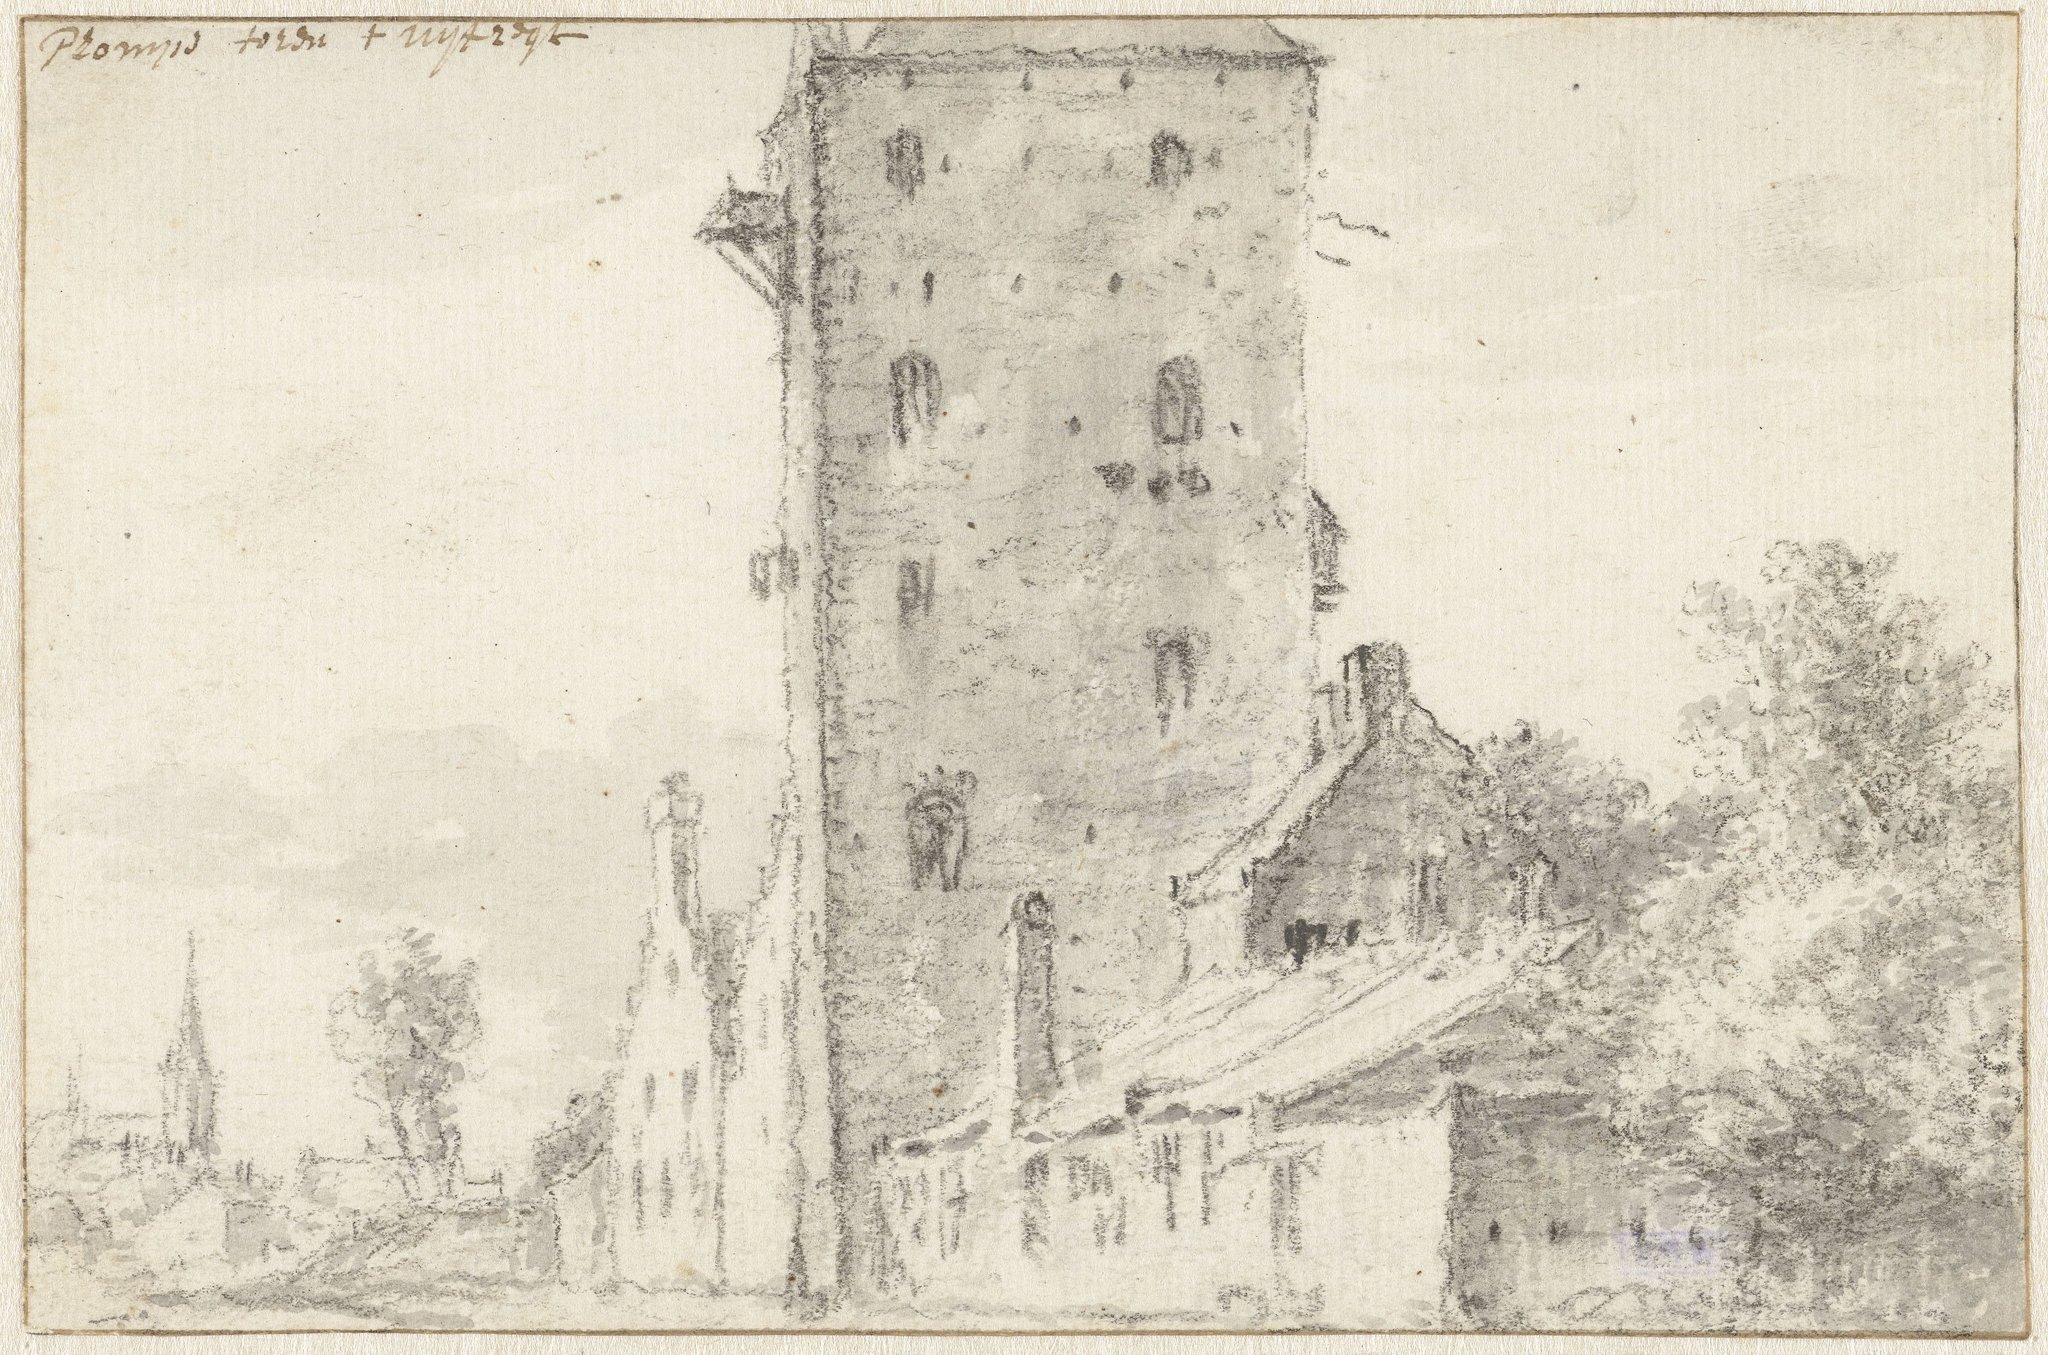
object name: drawing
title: Plompetoren te Utrecht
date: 1619-1690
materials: chalk, paper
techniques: brush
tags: public road, utrecht